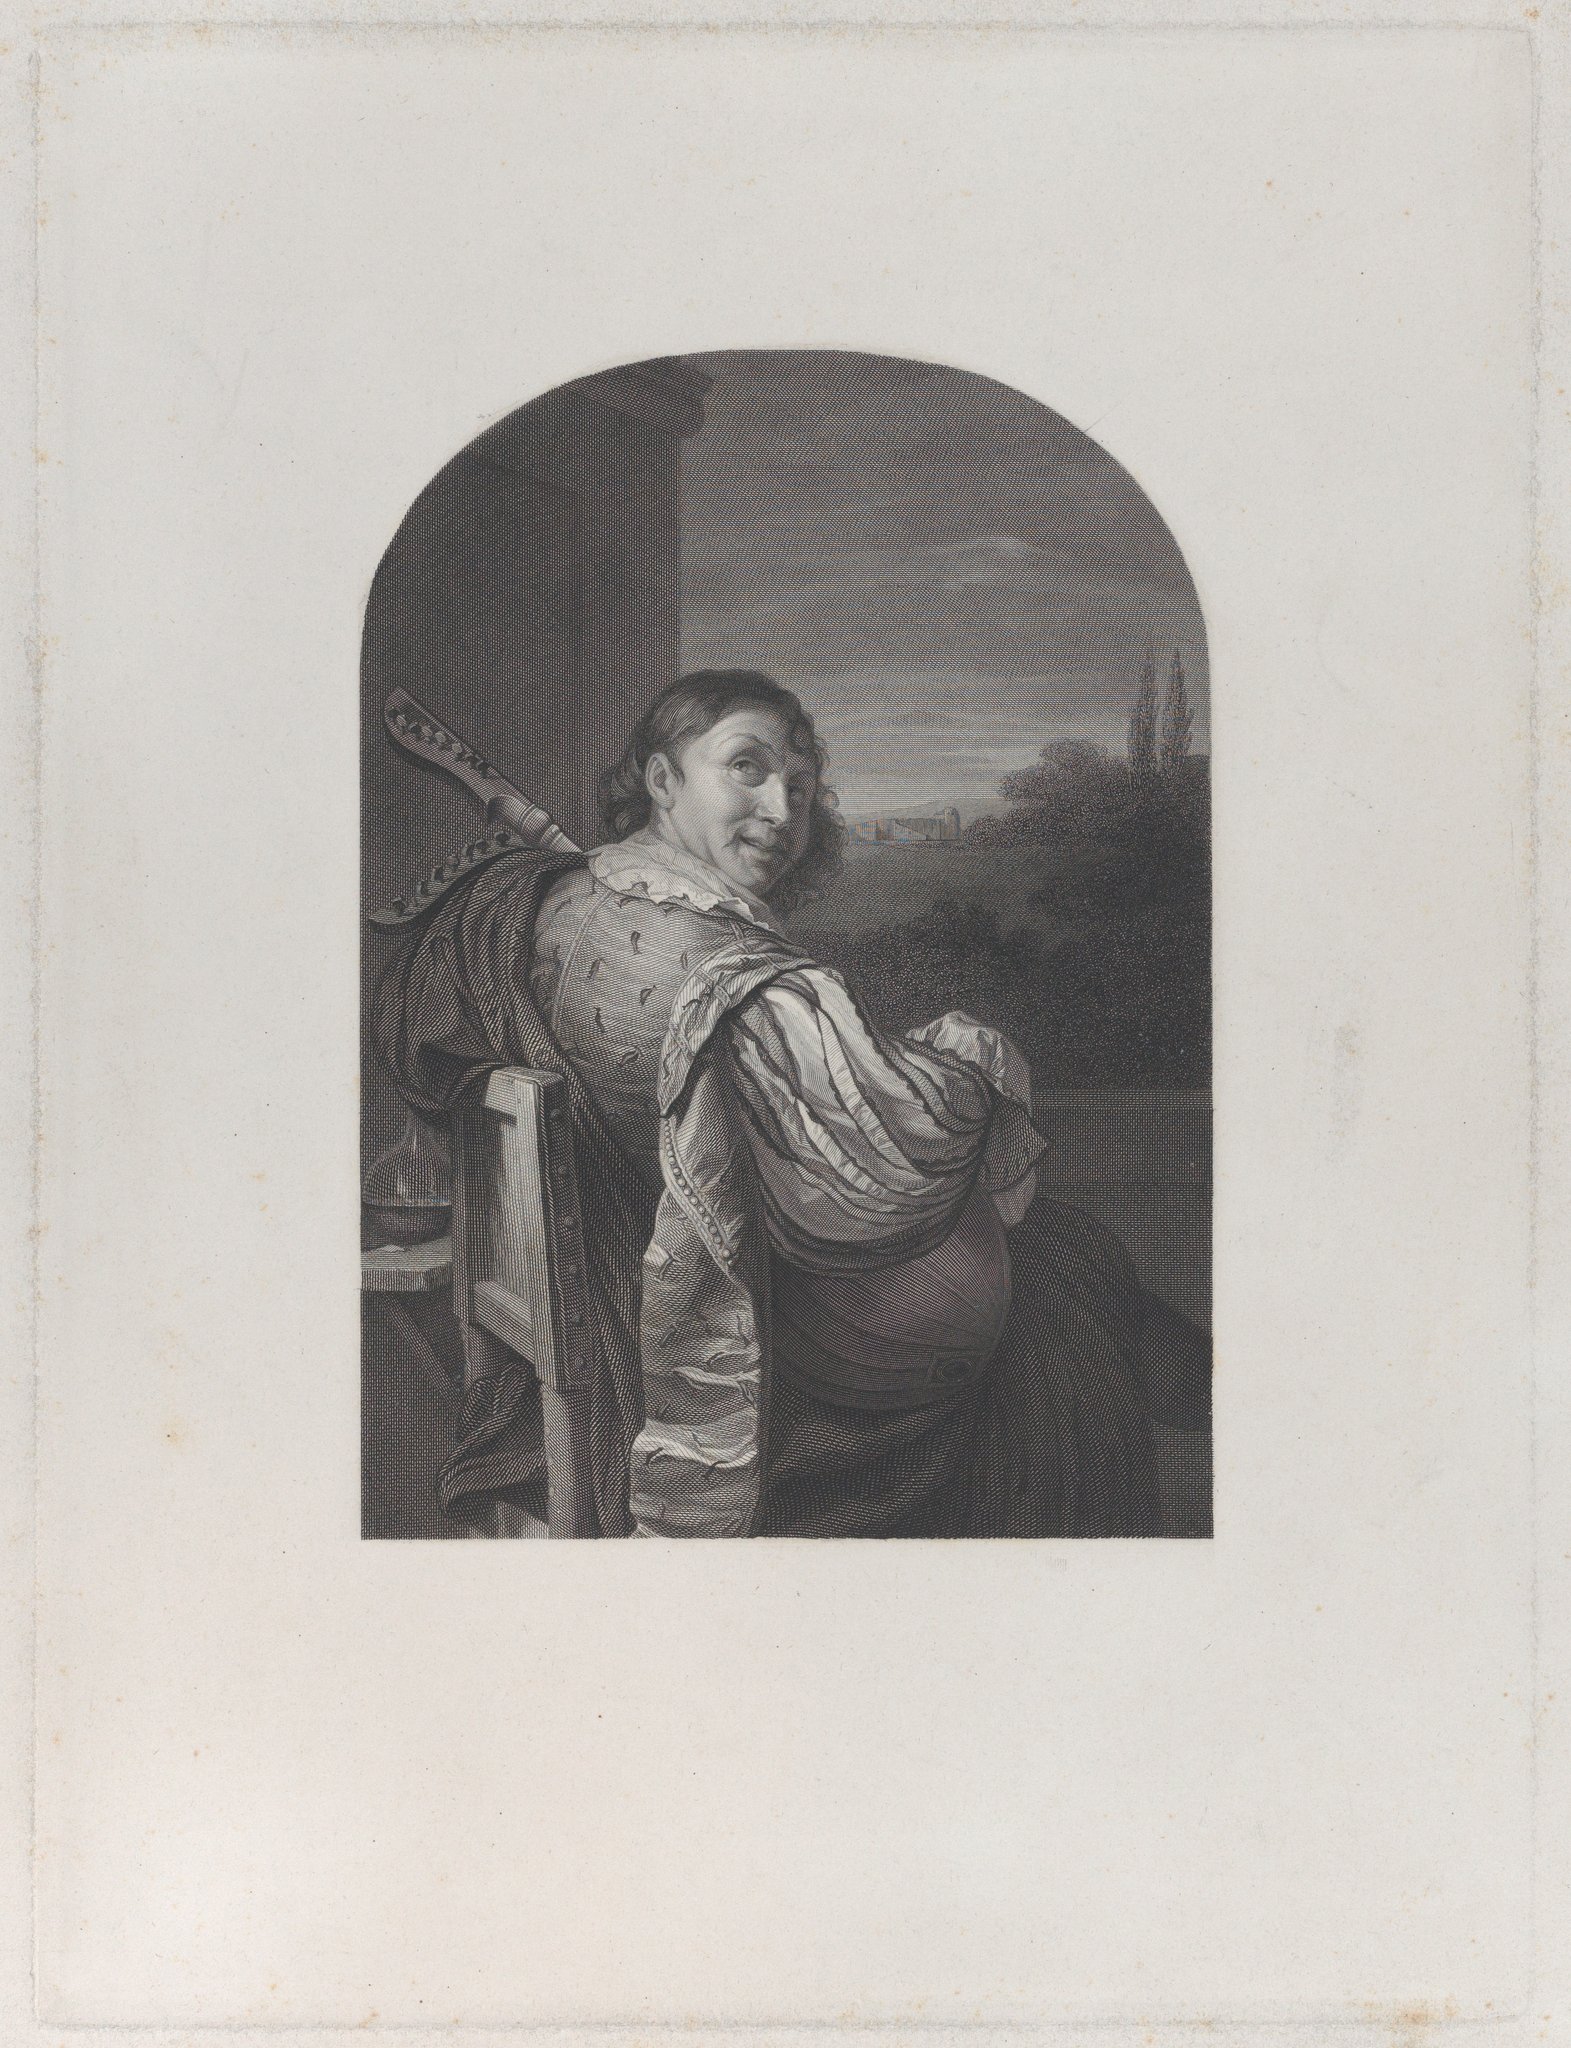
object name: print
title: Man seated with a musical instrument, seen from behind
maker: andrei franzowitsch belloli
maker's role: artist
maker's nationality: italian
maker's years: 1822-1881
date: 1842-1881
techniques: engraving